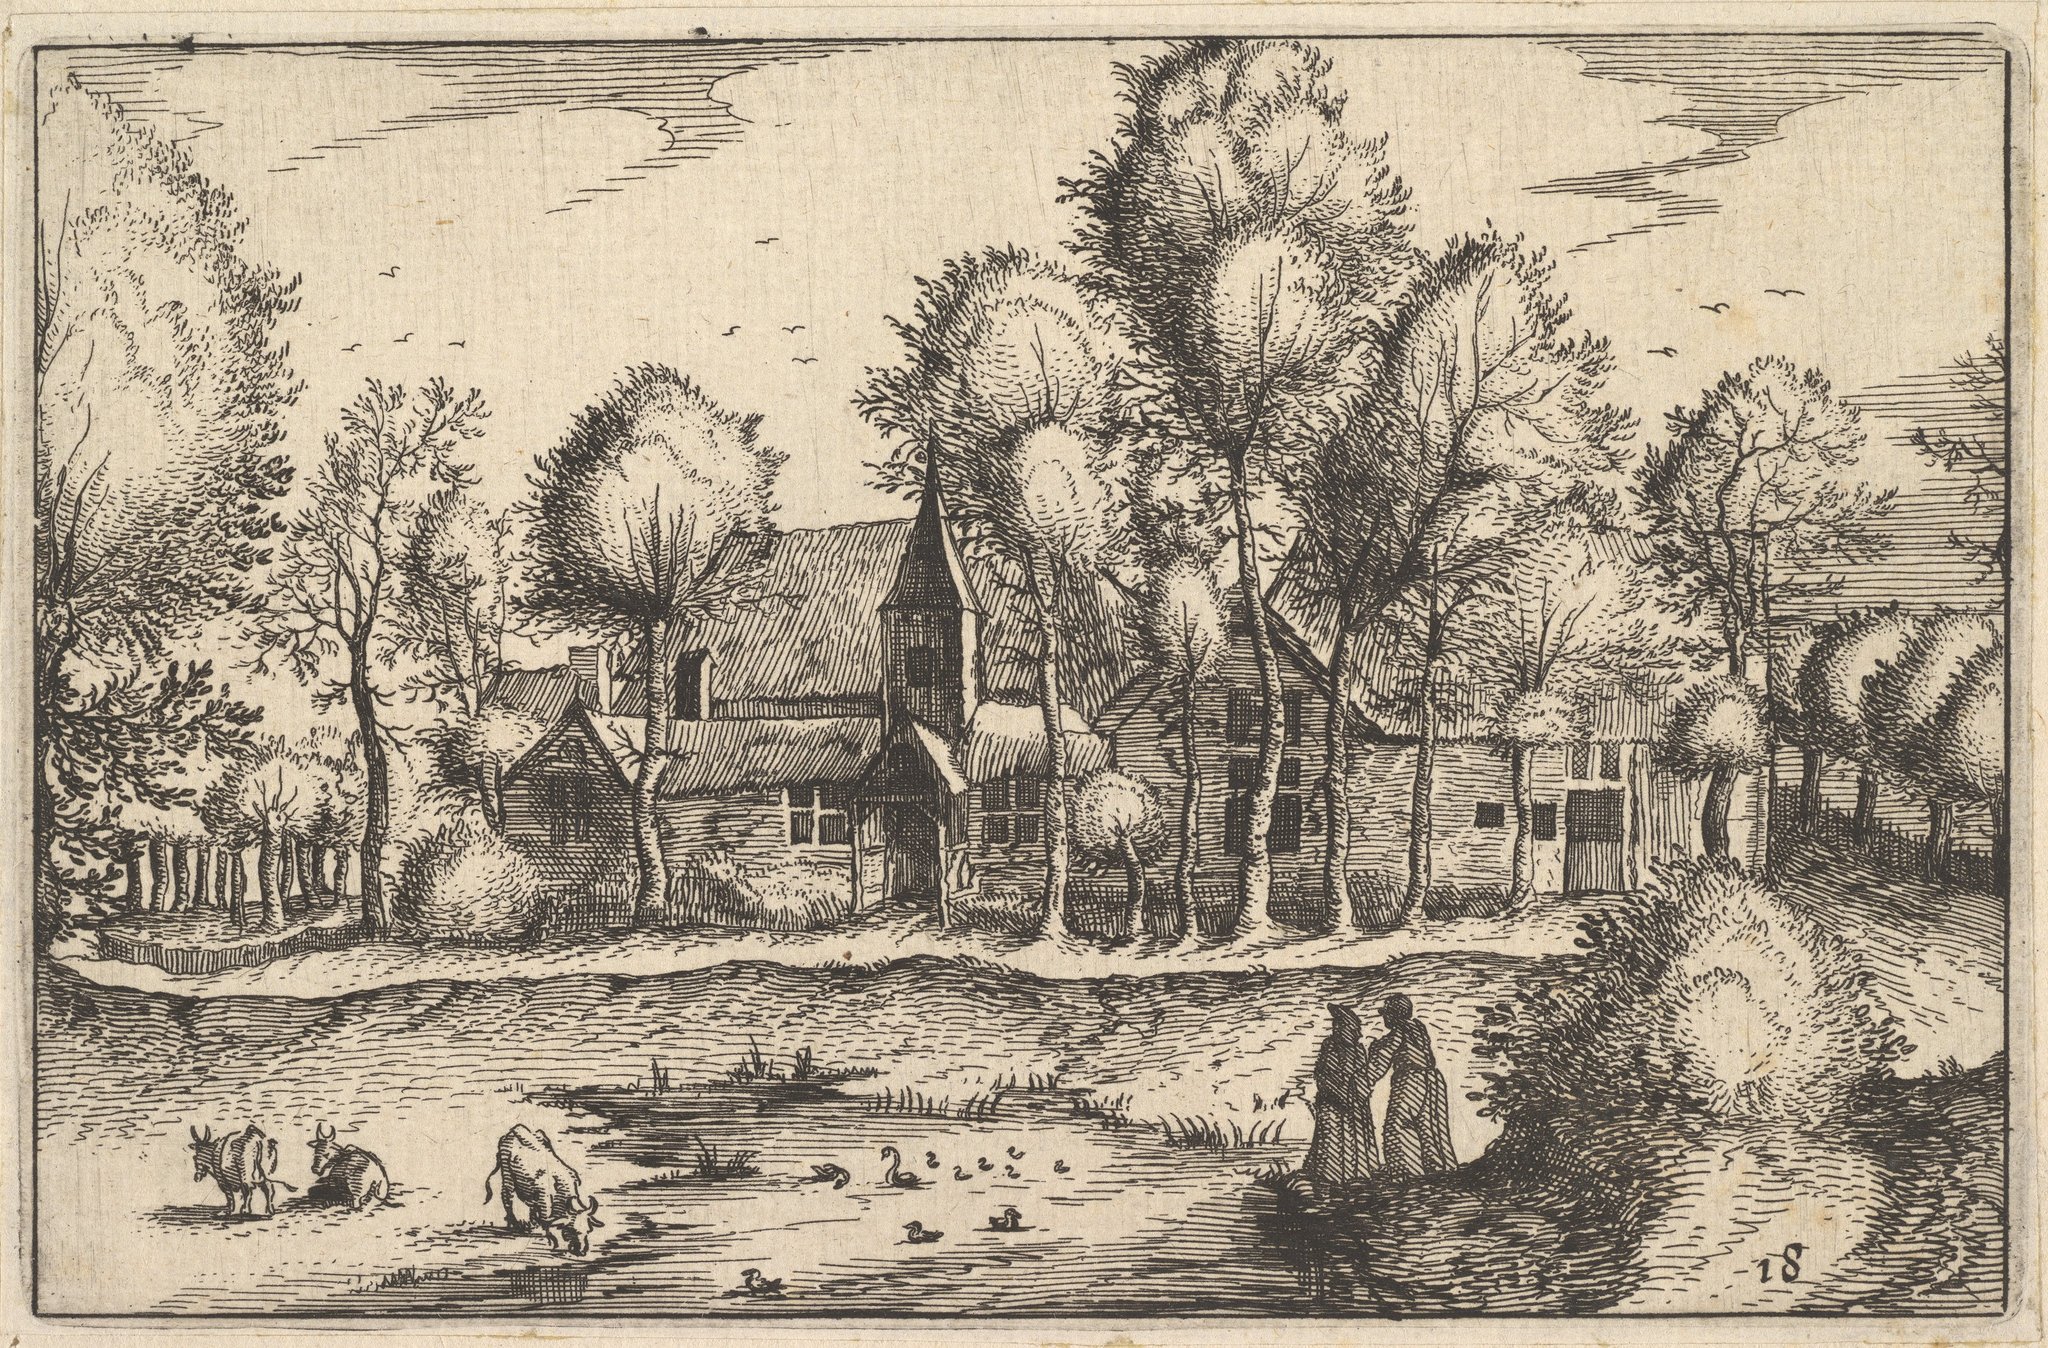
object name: print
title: A Pond, plate 18 from "Regiunculae et Villae Aliquot Ducatus Brabantiae"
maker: claes jansz. visscher (ii)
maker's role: artist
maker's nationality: dutch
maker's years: 1586-1652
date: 1610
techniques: etching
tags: human figures,houses,towns,cows,ponds,trees